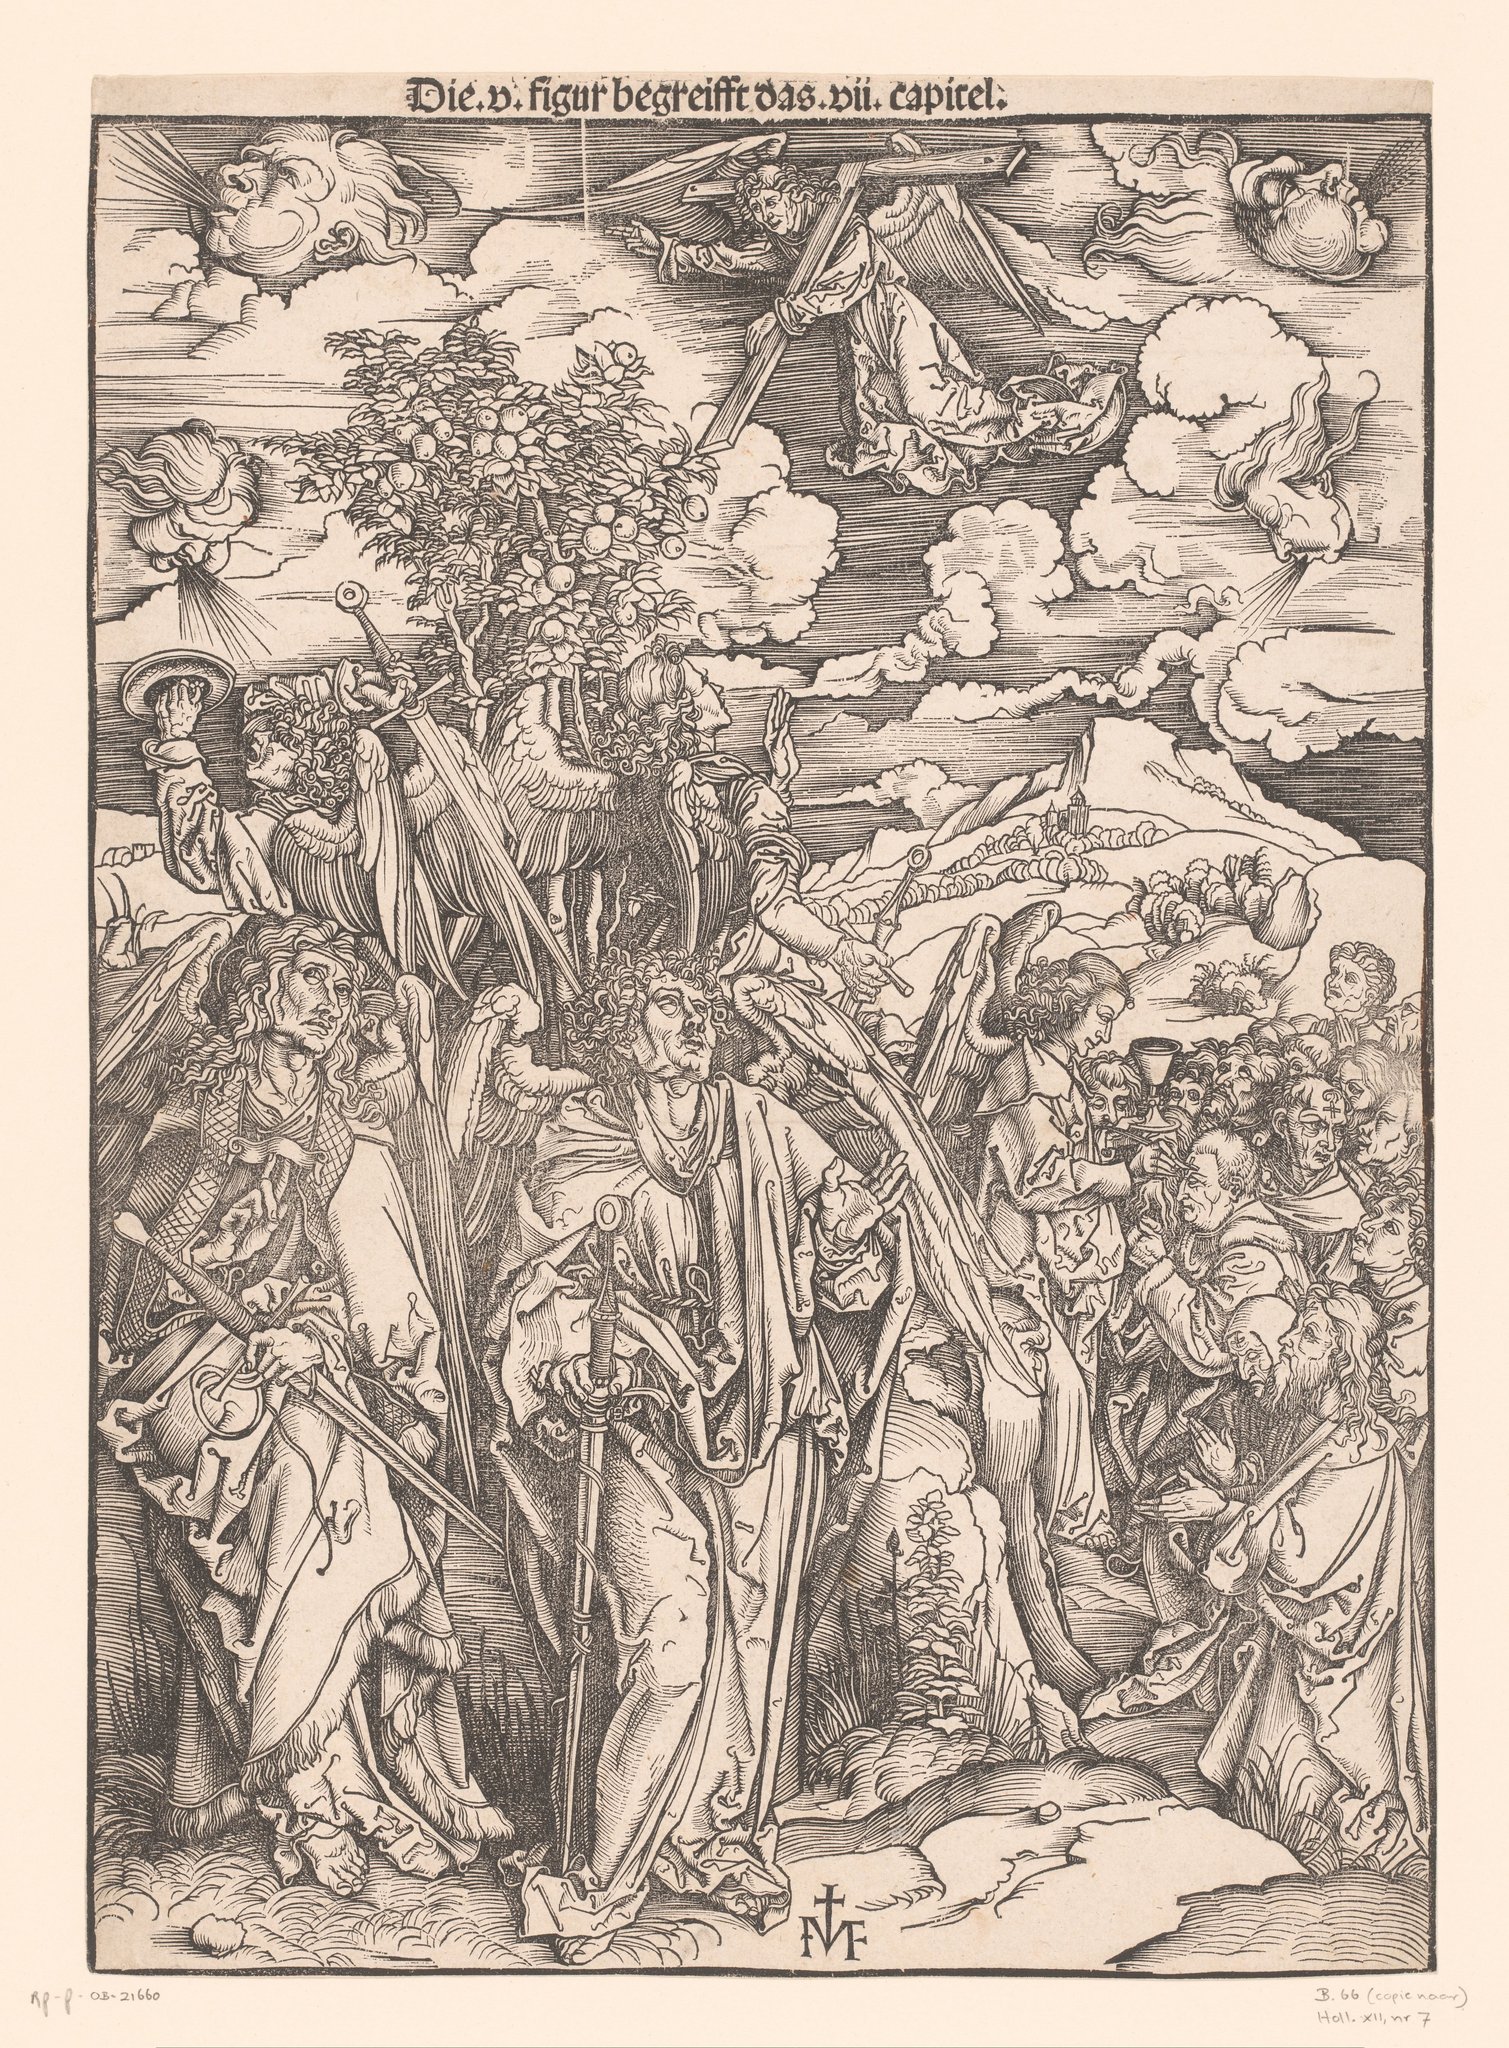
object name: print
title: Engelen houden de winden tegen en de verzegeling van de uitverkorenen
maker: ieronimus greff von frankfurt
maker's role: painter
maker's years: -1502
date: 1502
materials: paper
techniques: woodcut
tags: the four winds are restrained by four angels, sealing of the tribes of israel, the 144-thousand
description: Vier engelen houden de vier winden tegen, die de grote wereldrijken uit de Oudheid symboliseren. Een andere engel brengt het teken van God aan op de voorhoofden van de 144.000 zonen van Israël.